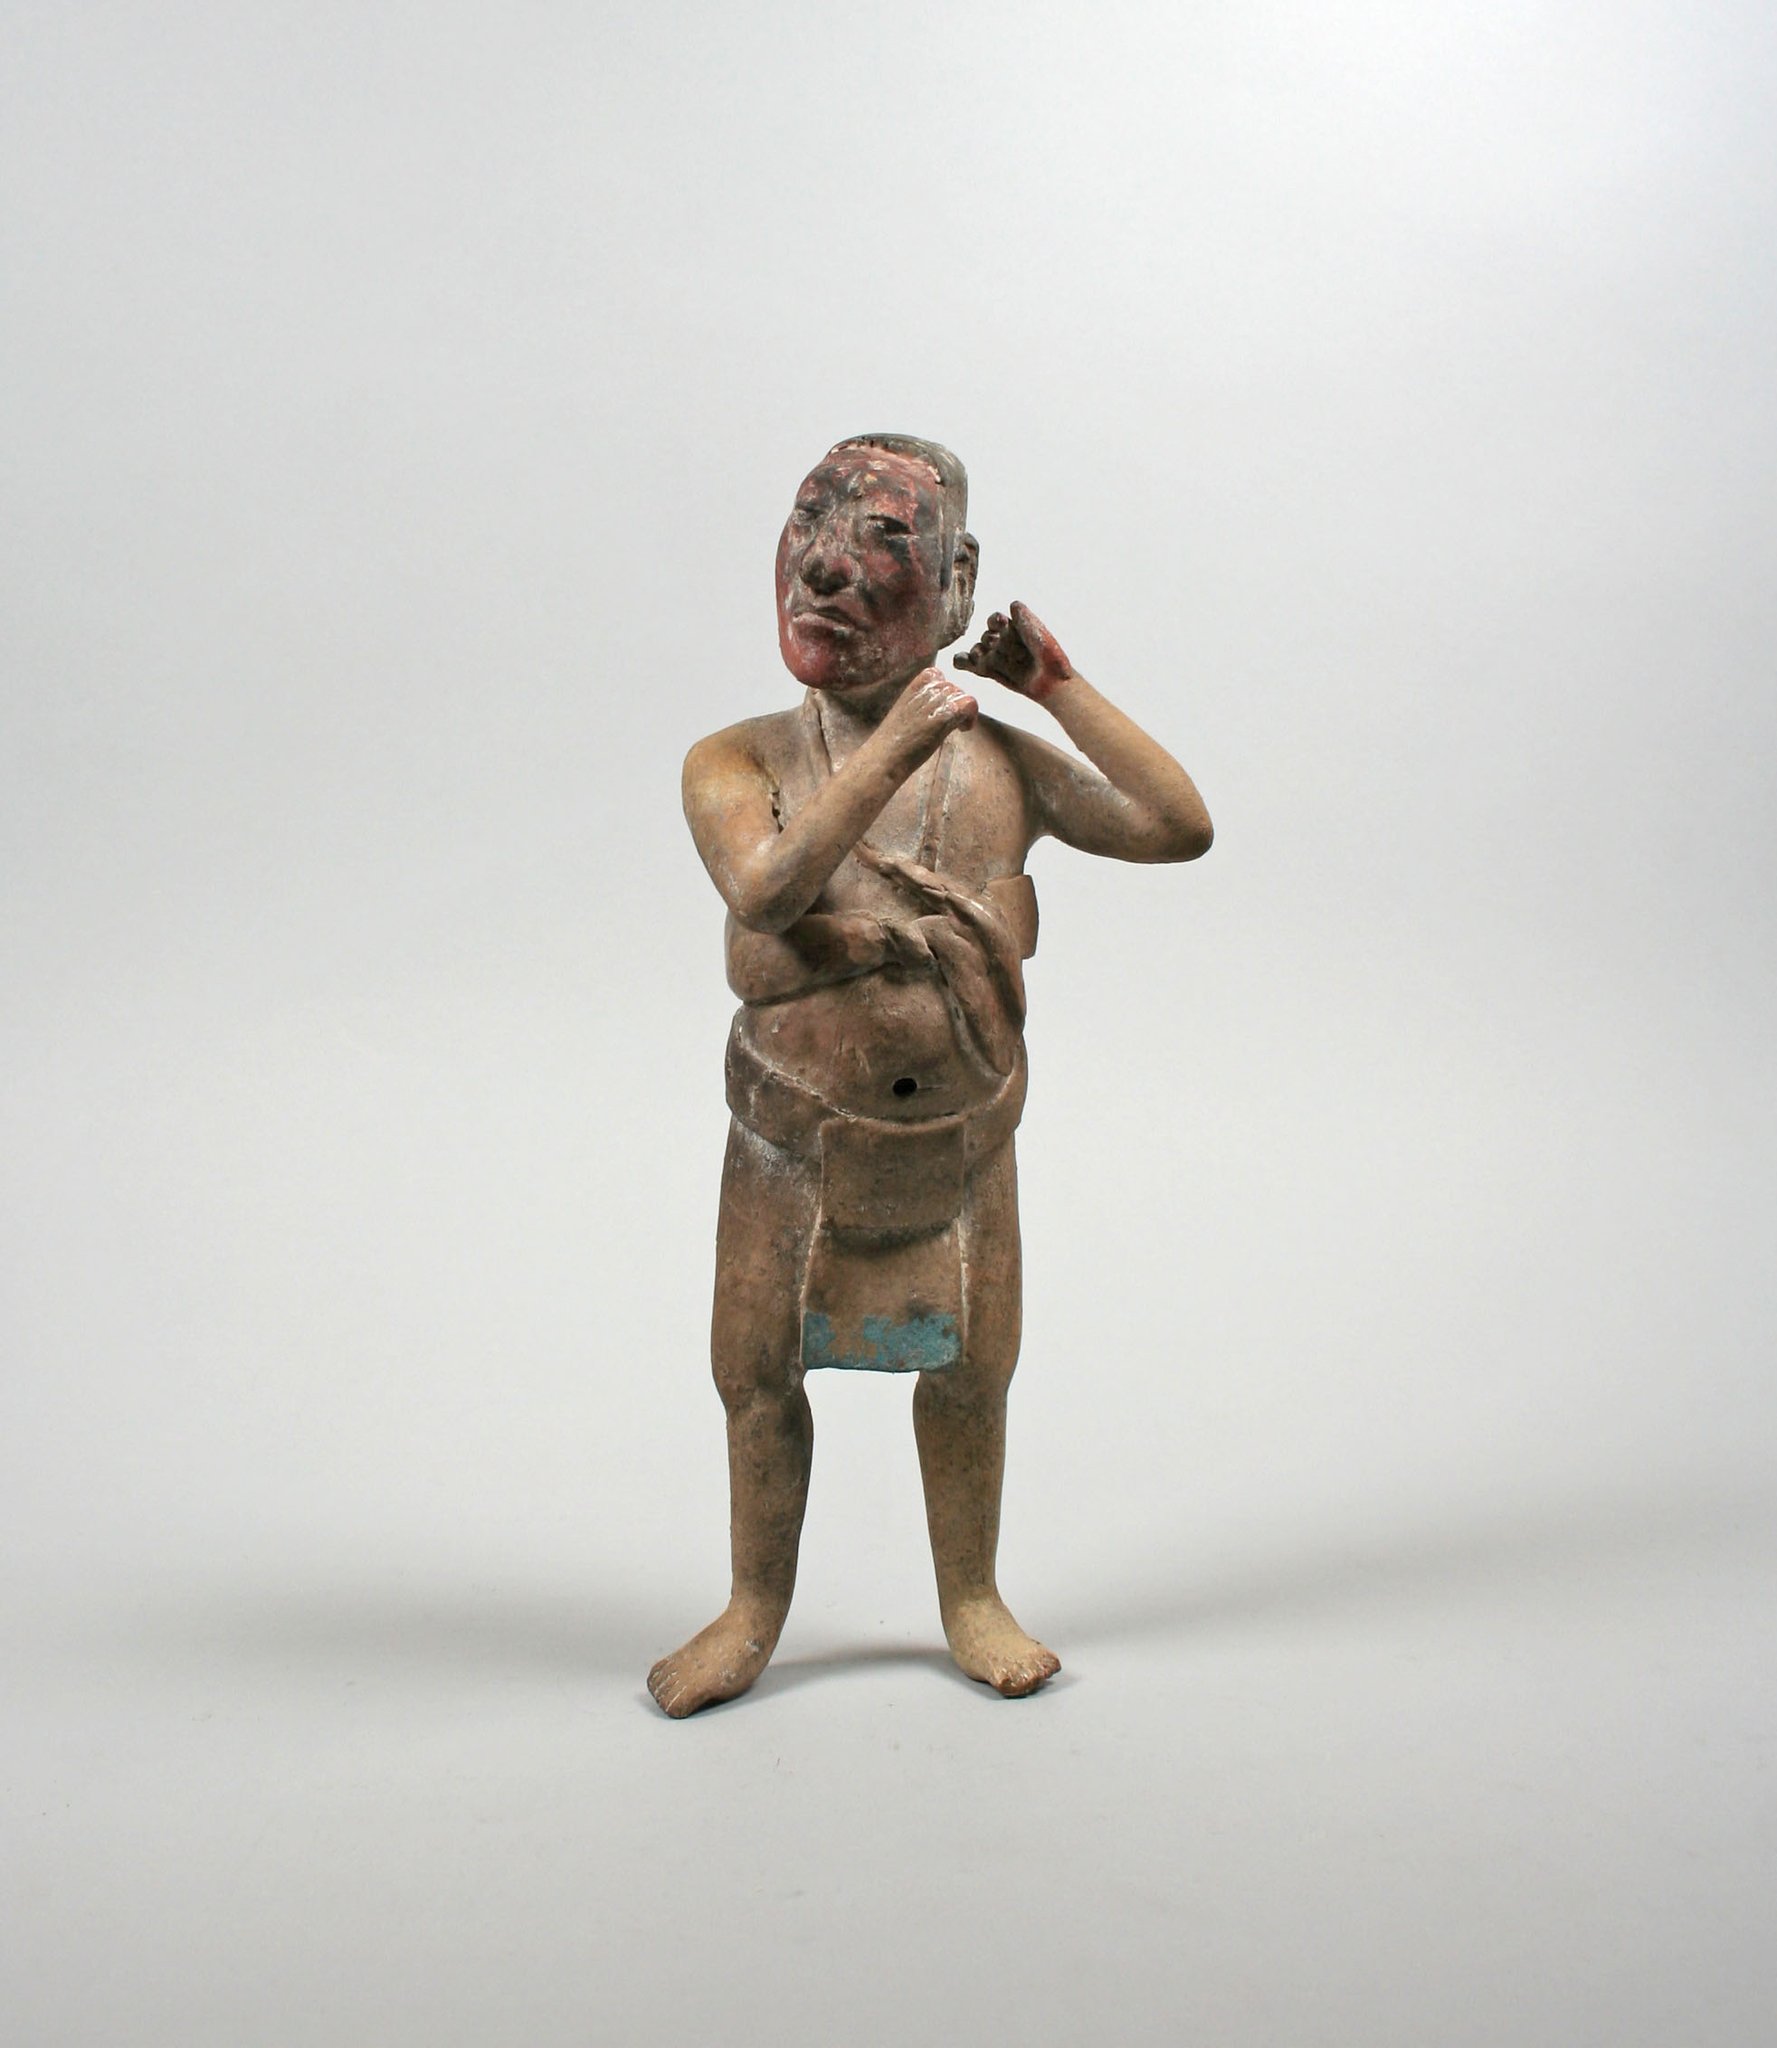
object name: male figure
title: Standing Male Figure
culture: maya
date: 601-800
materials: ceramic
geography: mexico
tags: men